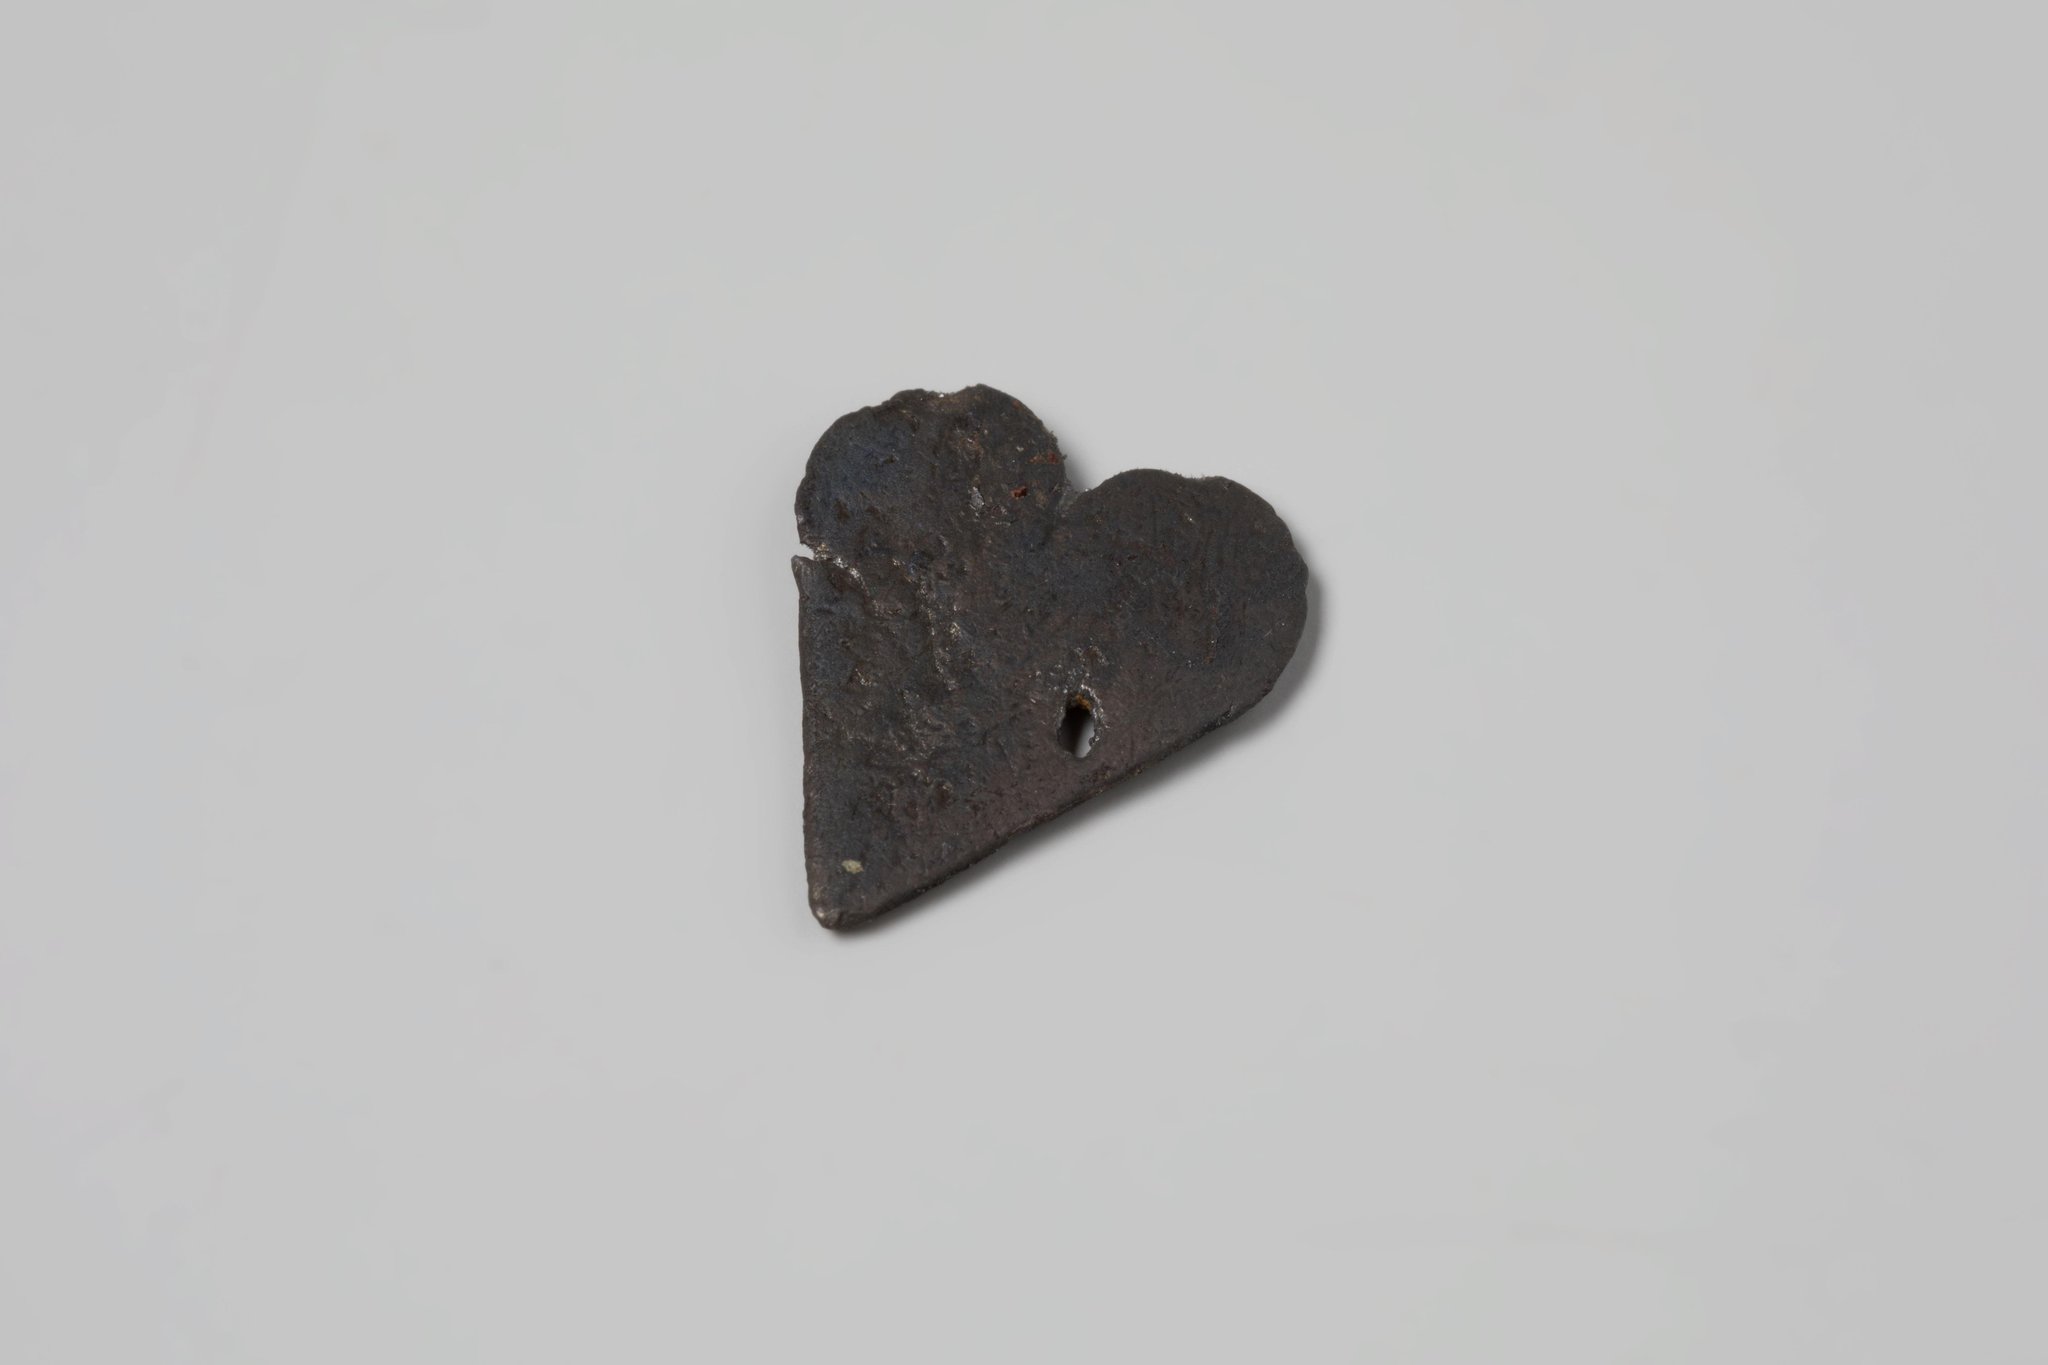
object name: beslag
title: Decoratief beslag uit het wrak van de Oost-Indiëvaarder Hollandia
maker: Anonymous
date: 1700-1743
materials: silver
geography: netherlands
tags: verenigde oostindische compagnie, hollandia (schip), annet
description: Fitting, decorative fitting or fragment; eroded, heart-shaped, flat, solder on underside.